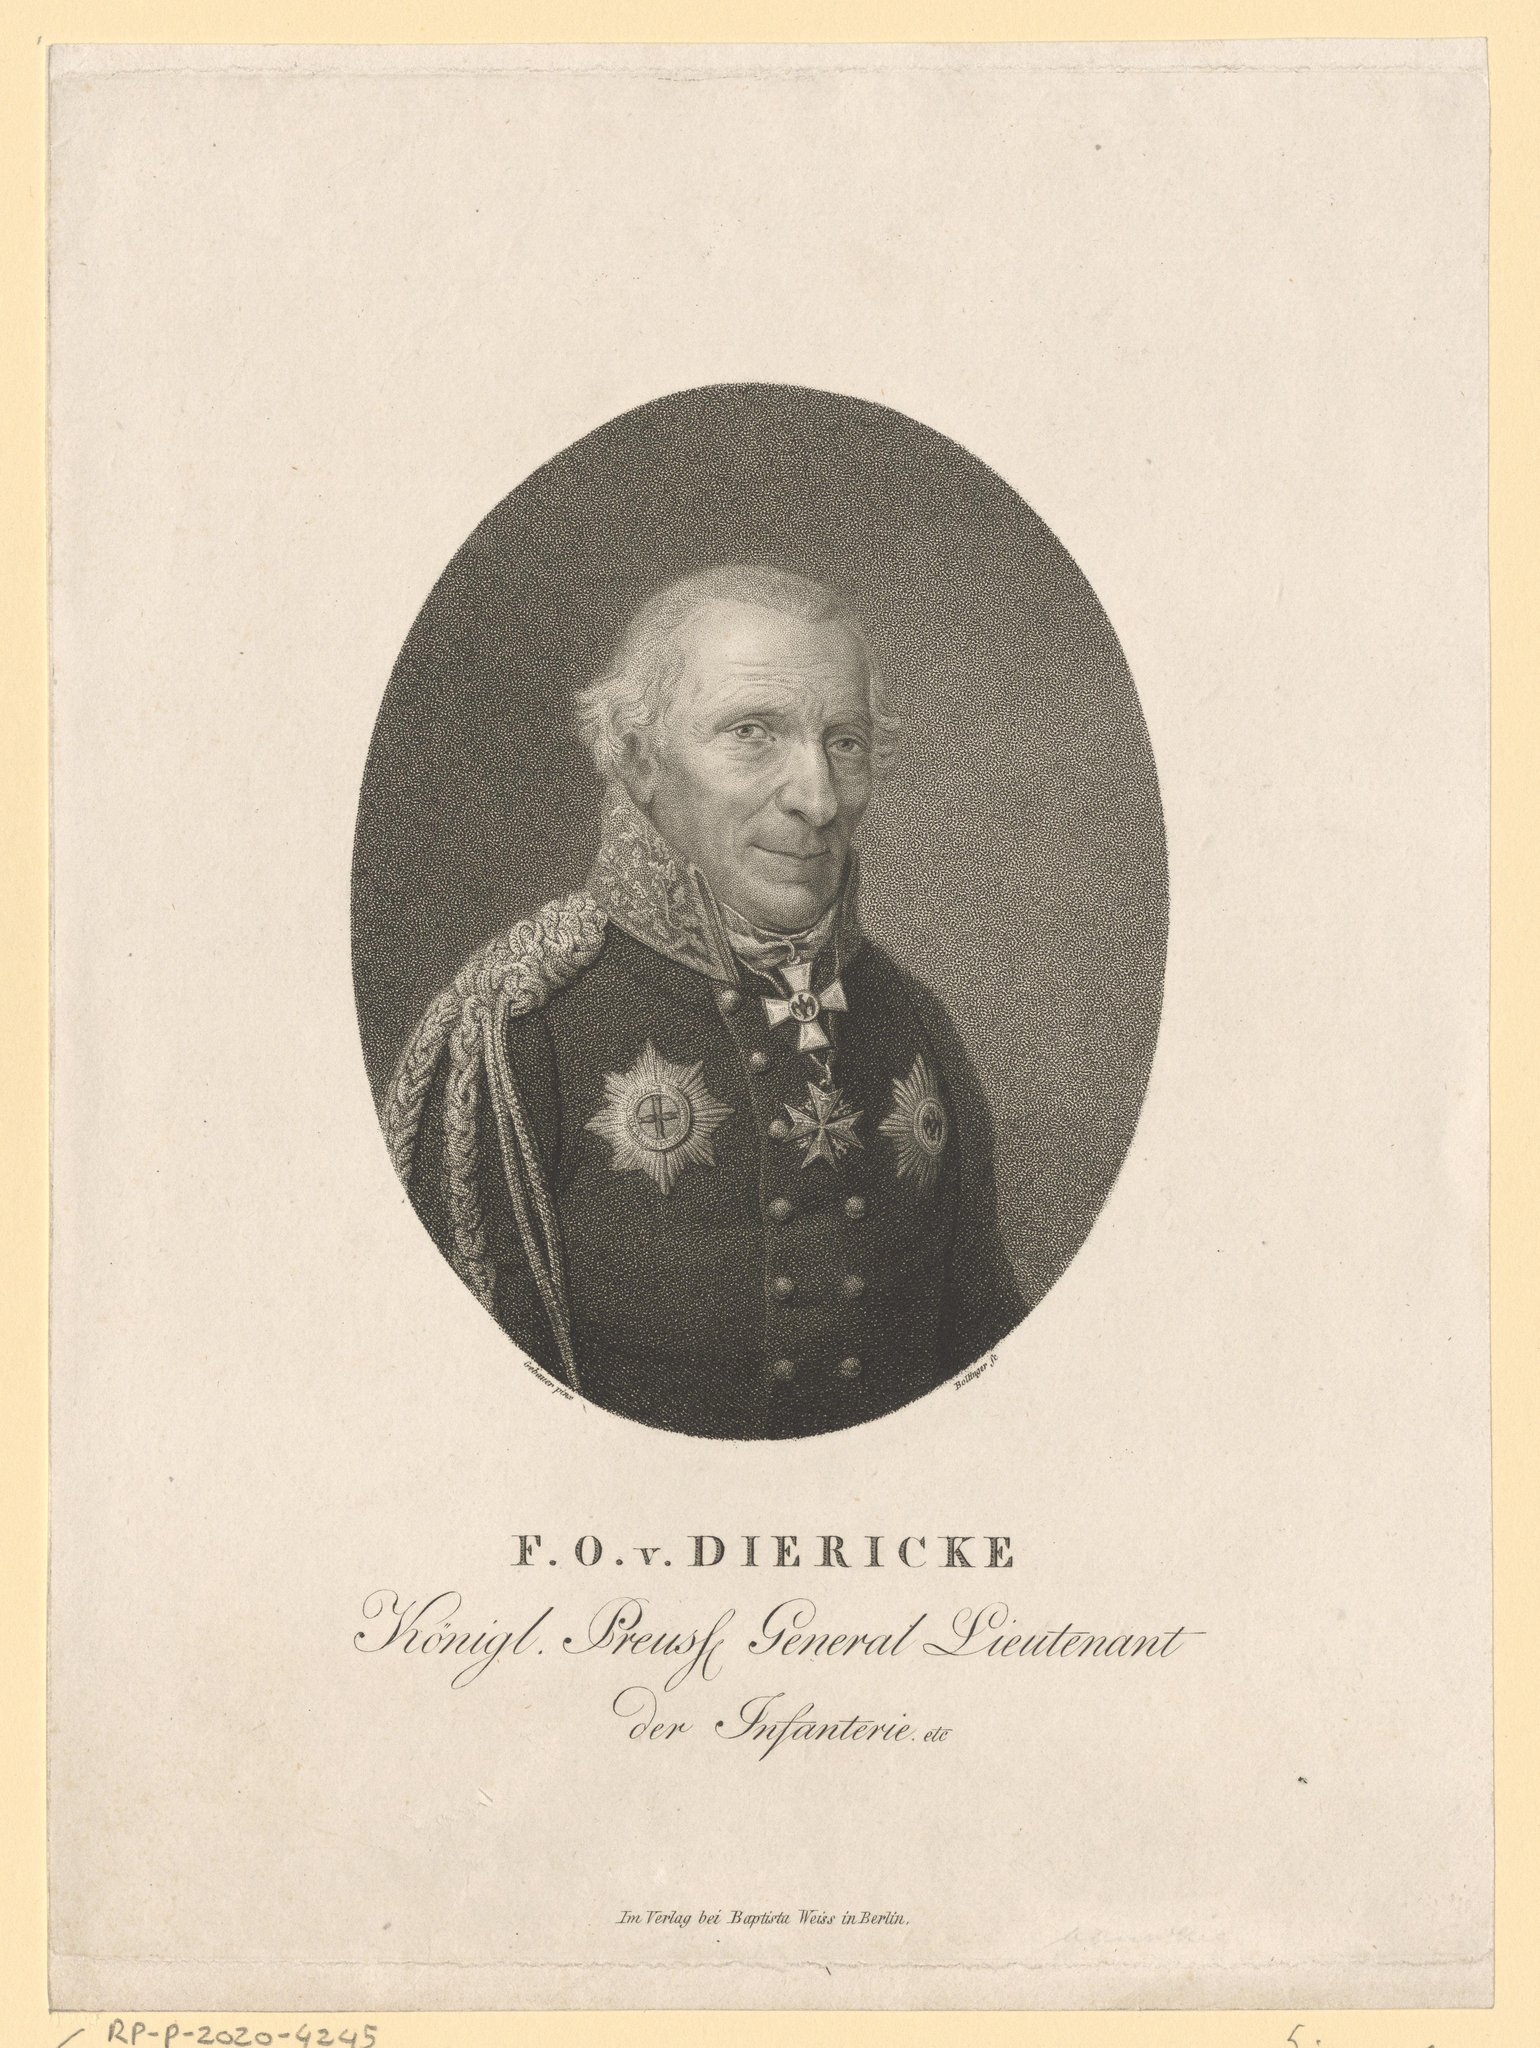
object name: print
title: Portret van Christoph Friedrich Otto von Diericke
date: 1814-1825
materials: paper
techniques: etching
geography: berlin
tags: berlin, knighthood order, commander-in-chief, general, marshal, historical persons